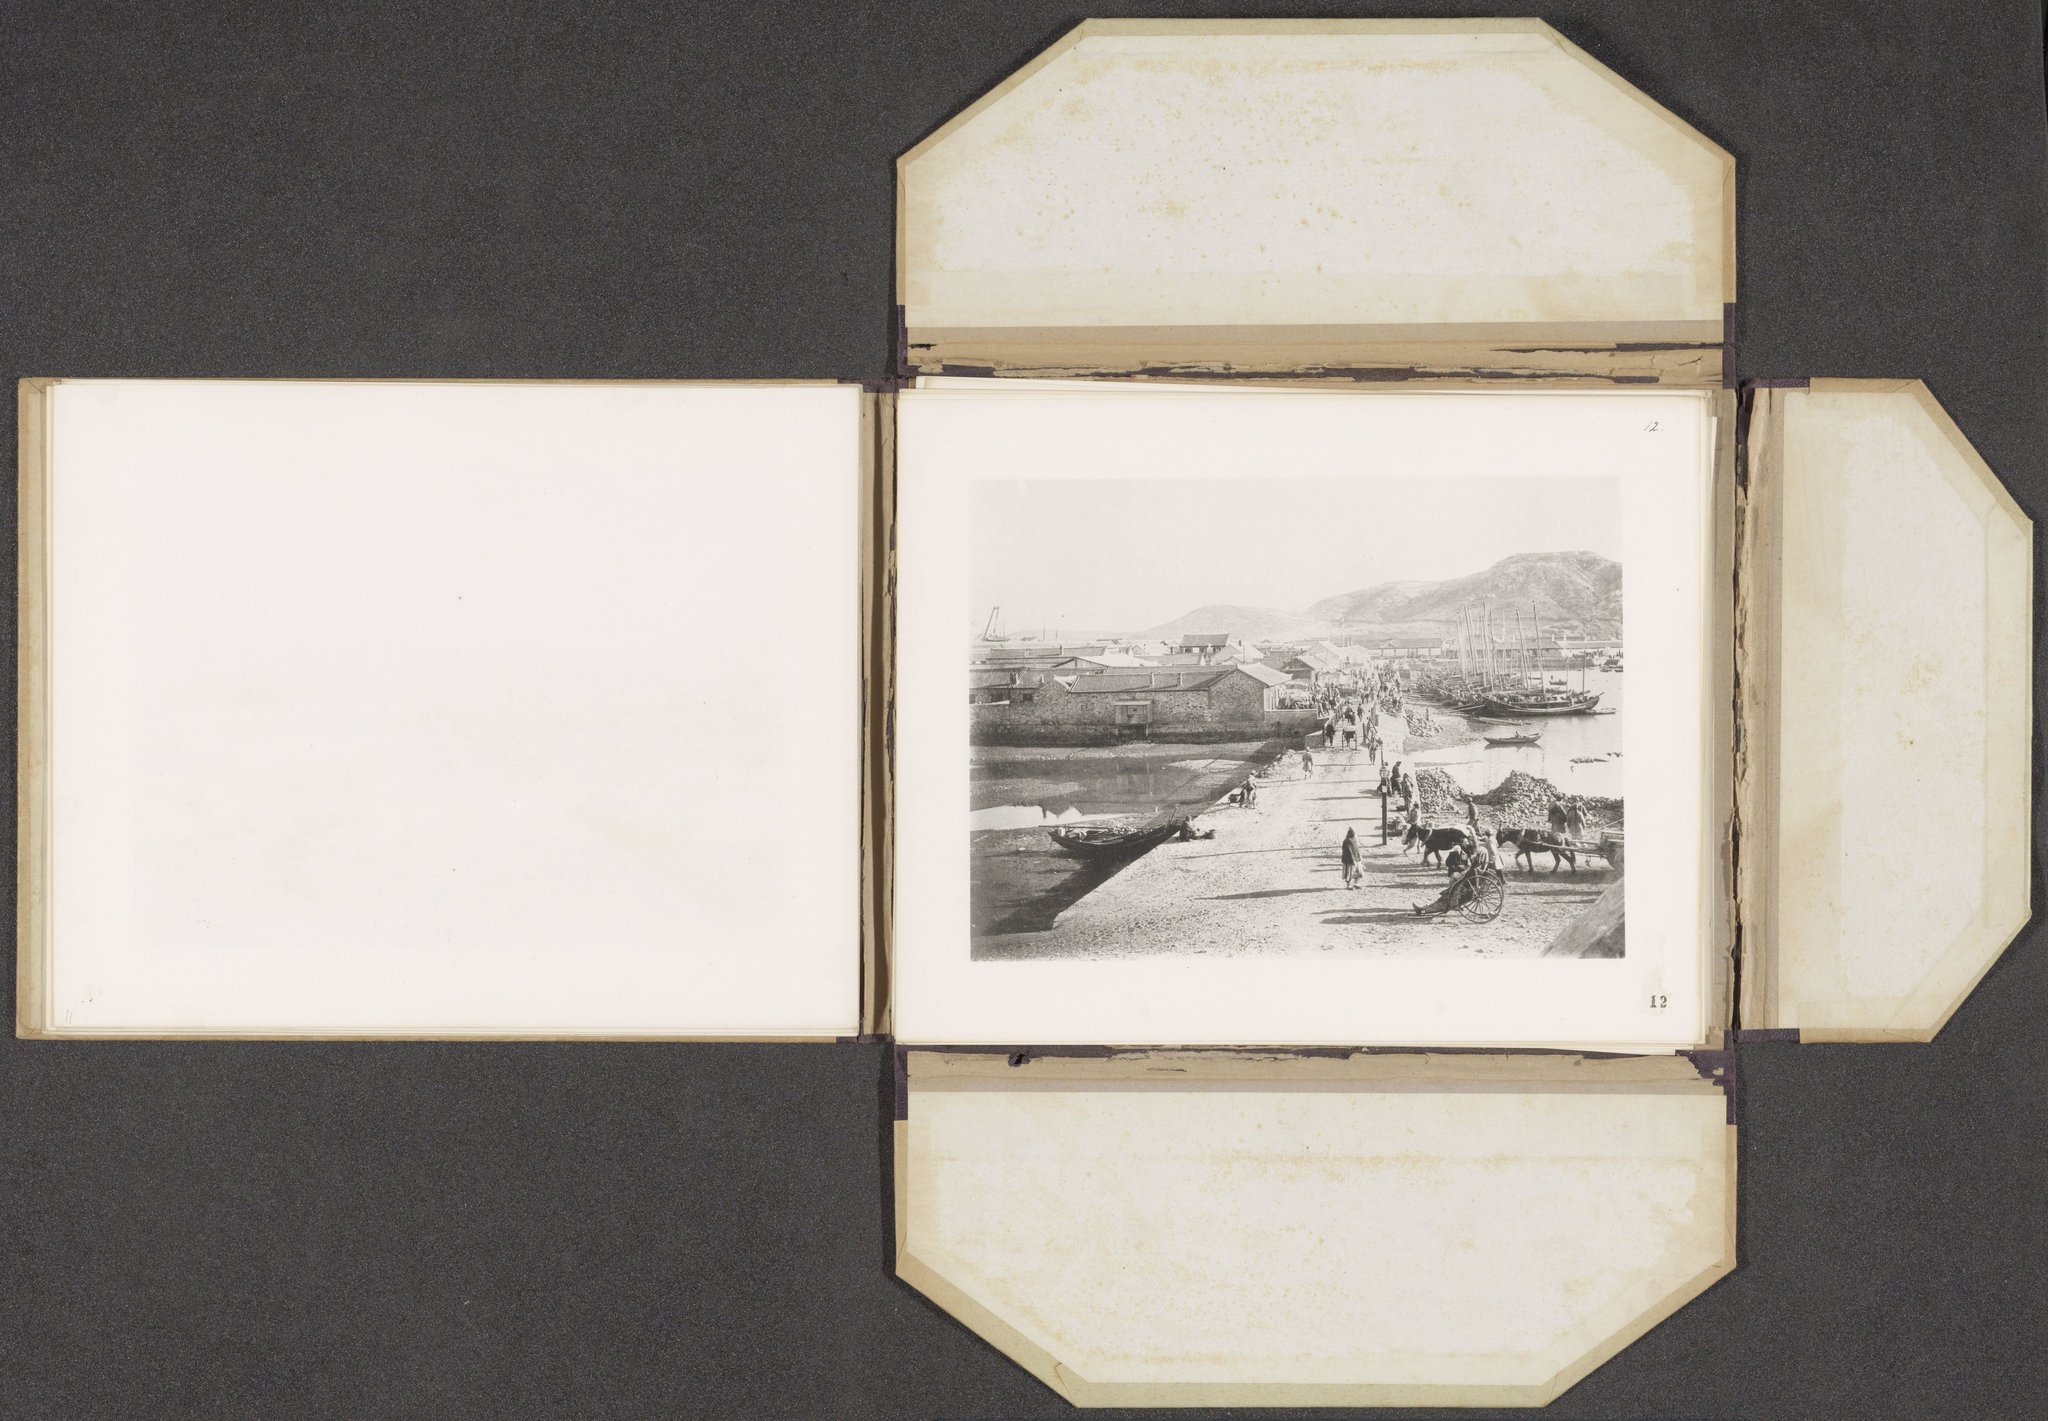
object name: photomechanical print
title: Gezicht op de kade van Port Arthur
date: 1898-1899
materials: paper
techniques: photograph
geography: port arthur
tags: harbour, ships (in general), pier, quay, wharf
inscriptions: number: ‘12’